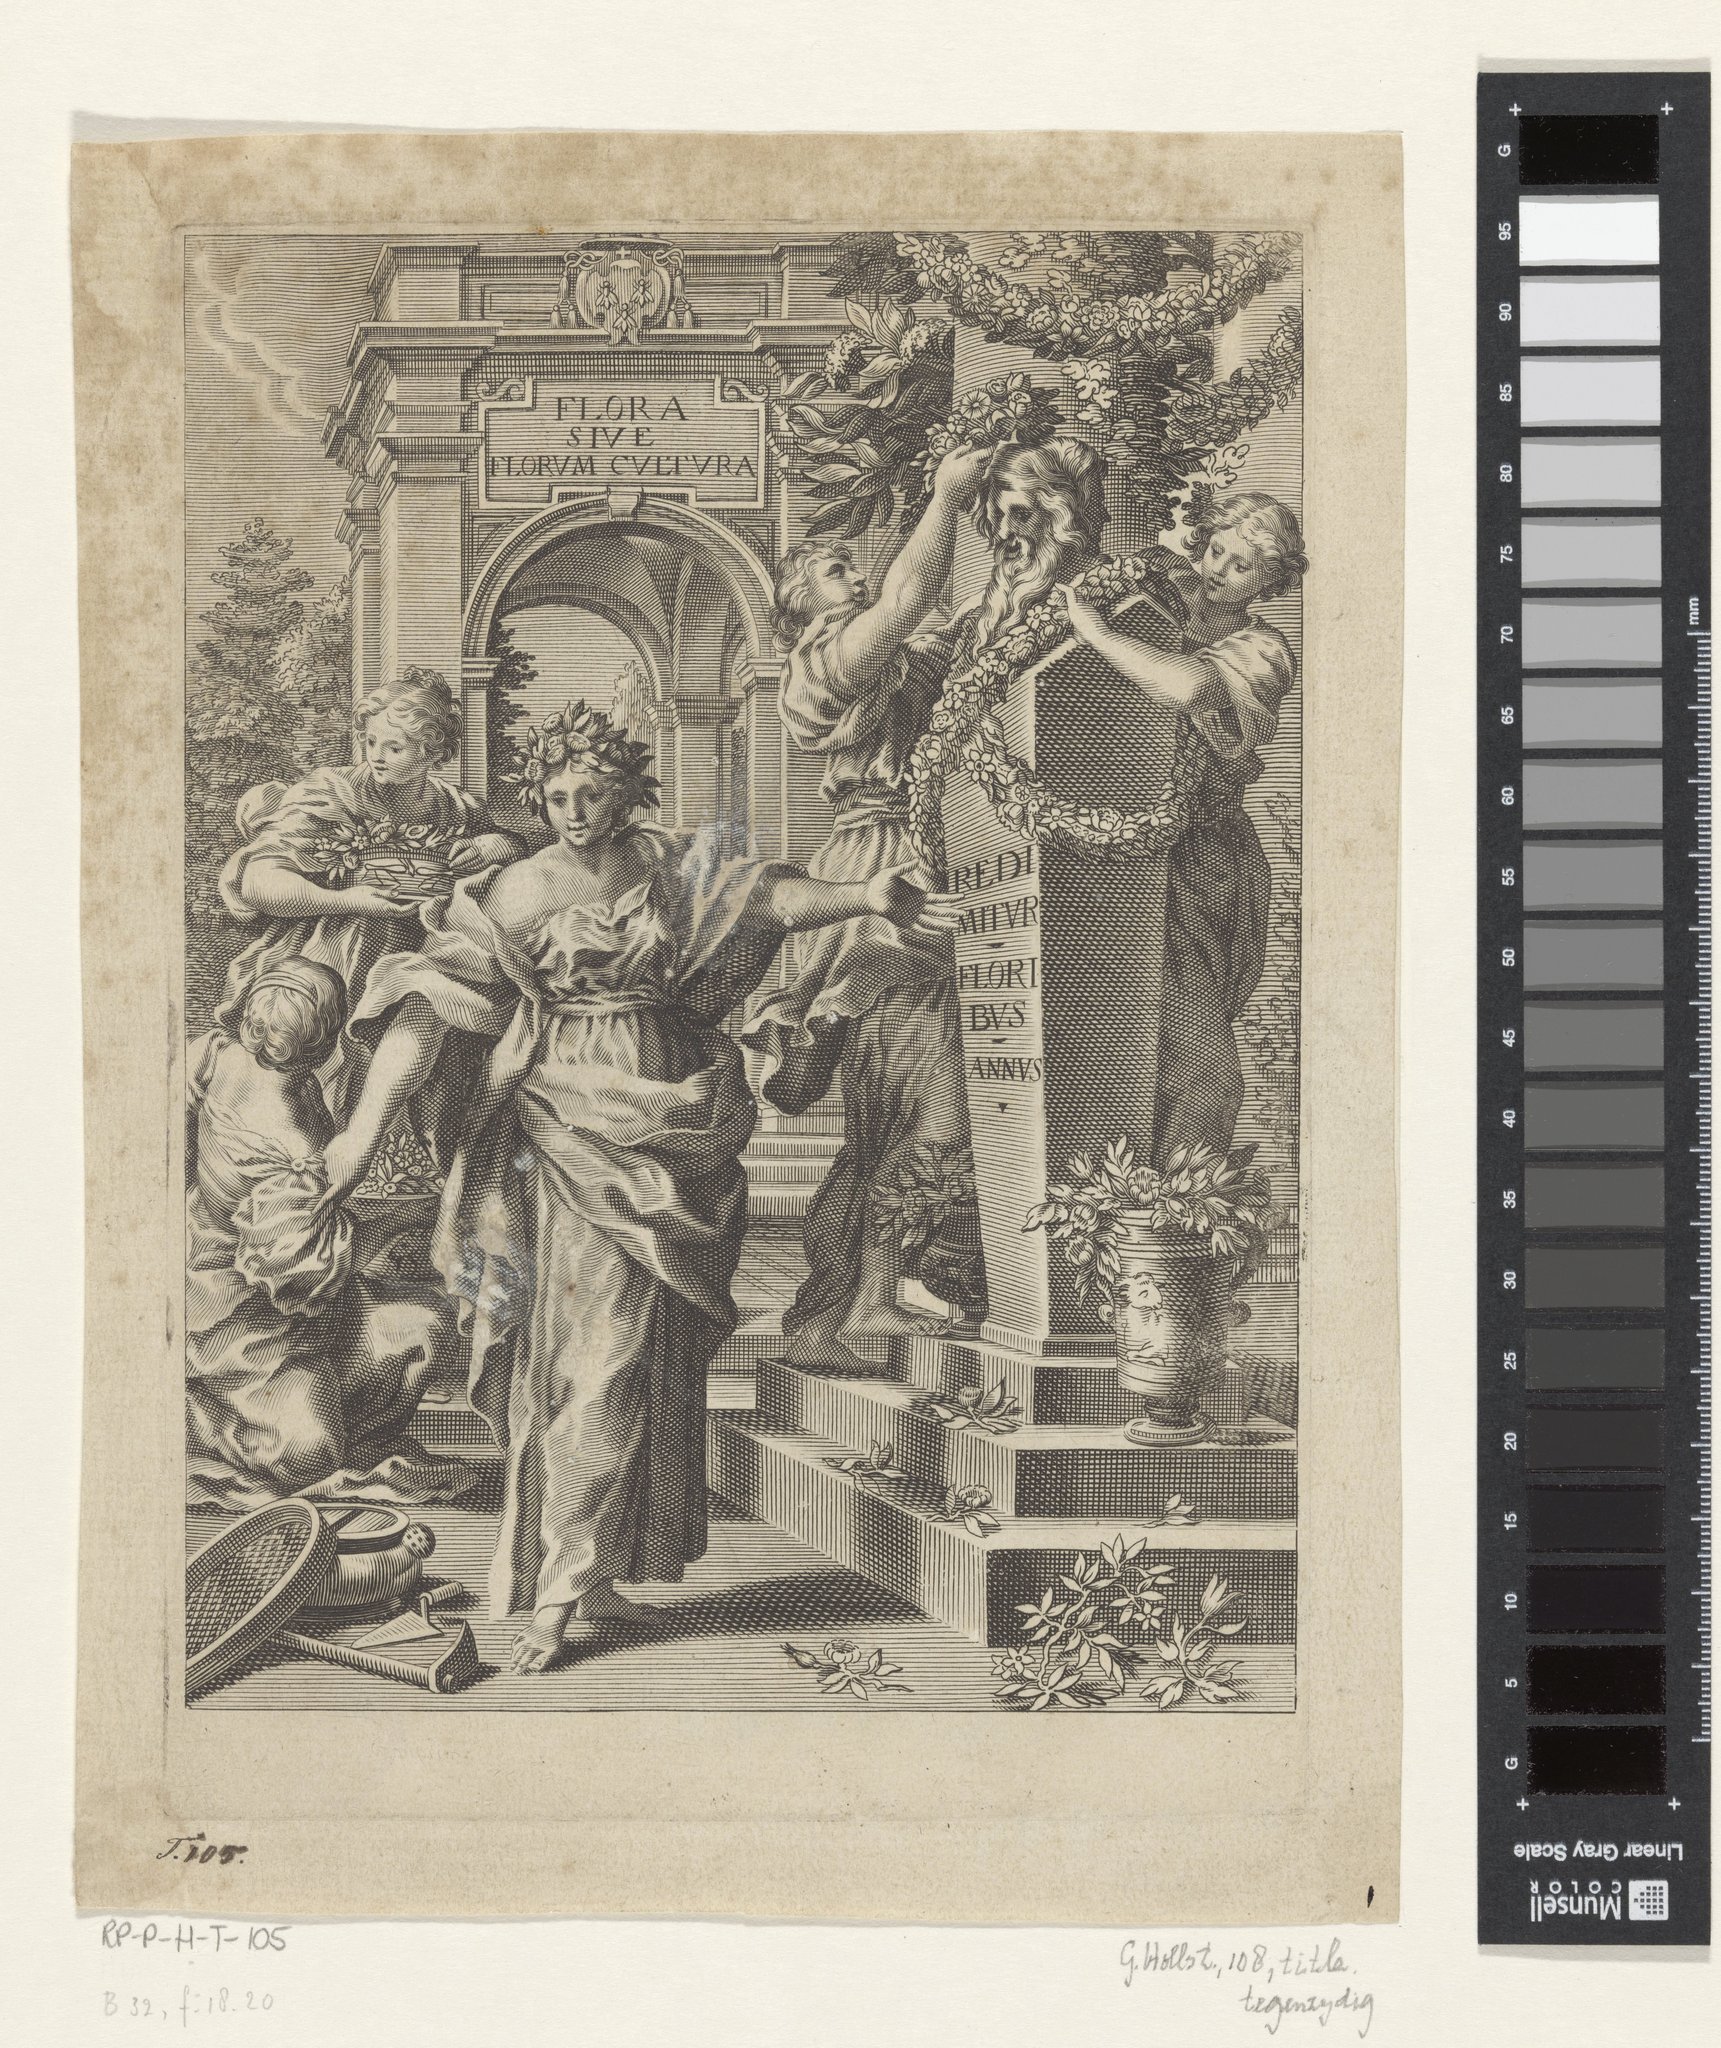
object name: print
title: Flora en haar metgezellinnen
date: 1633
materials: paper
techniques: engraving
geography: italy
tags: nymphs (in general); 'ninfe in commune' (ripa), piece of sculpture, reproduction of a piece of sculpture, (story of) flora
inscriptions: collector's mark: ‘Hinloopen’, number: ‘1’, collector's mark: Lugt 11, number: ‘T. 105’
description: Spiegelbeeldige kopie naar een prent gebruikt als boekillustratie in: Ferrari, Giambattista. Flora/Sive/Florvm Cvltvra, Libri IV, Rome 1633 (Italiaanse editie: Ferrari, Giambattista. Flora/overo/Cvltvra di Fiori/Del P. Gio. Battista Ferrari Sanese/della Comp. di Giesù/Distinta in Quattro Libri/e trasportata dalla lingua Latina nell' Italiano/da Ludouico Aureli Perugino/In Roma Per Pier' Ant. Facciotti. 1638).